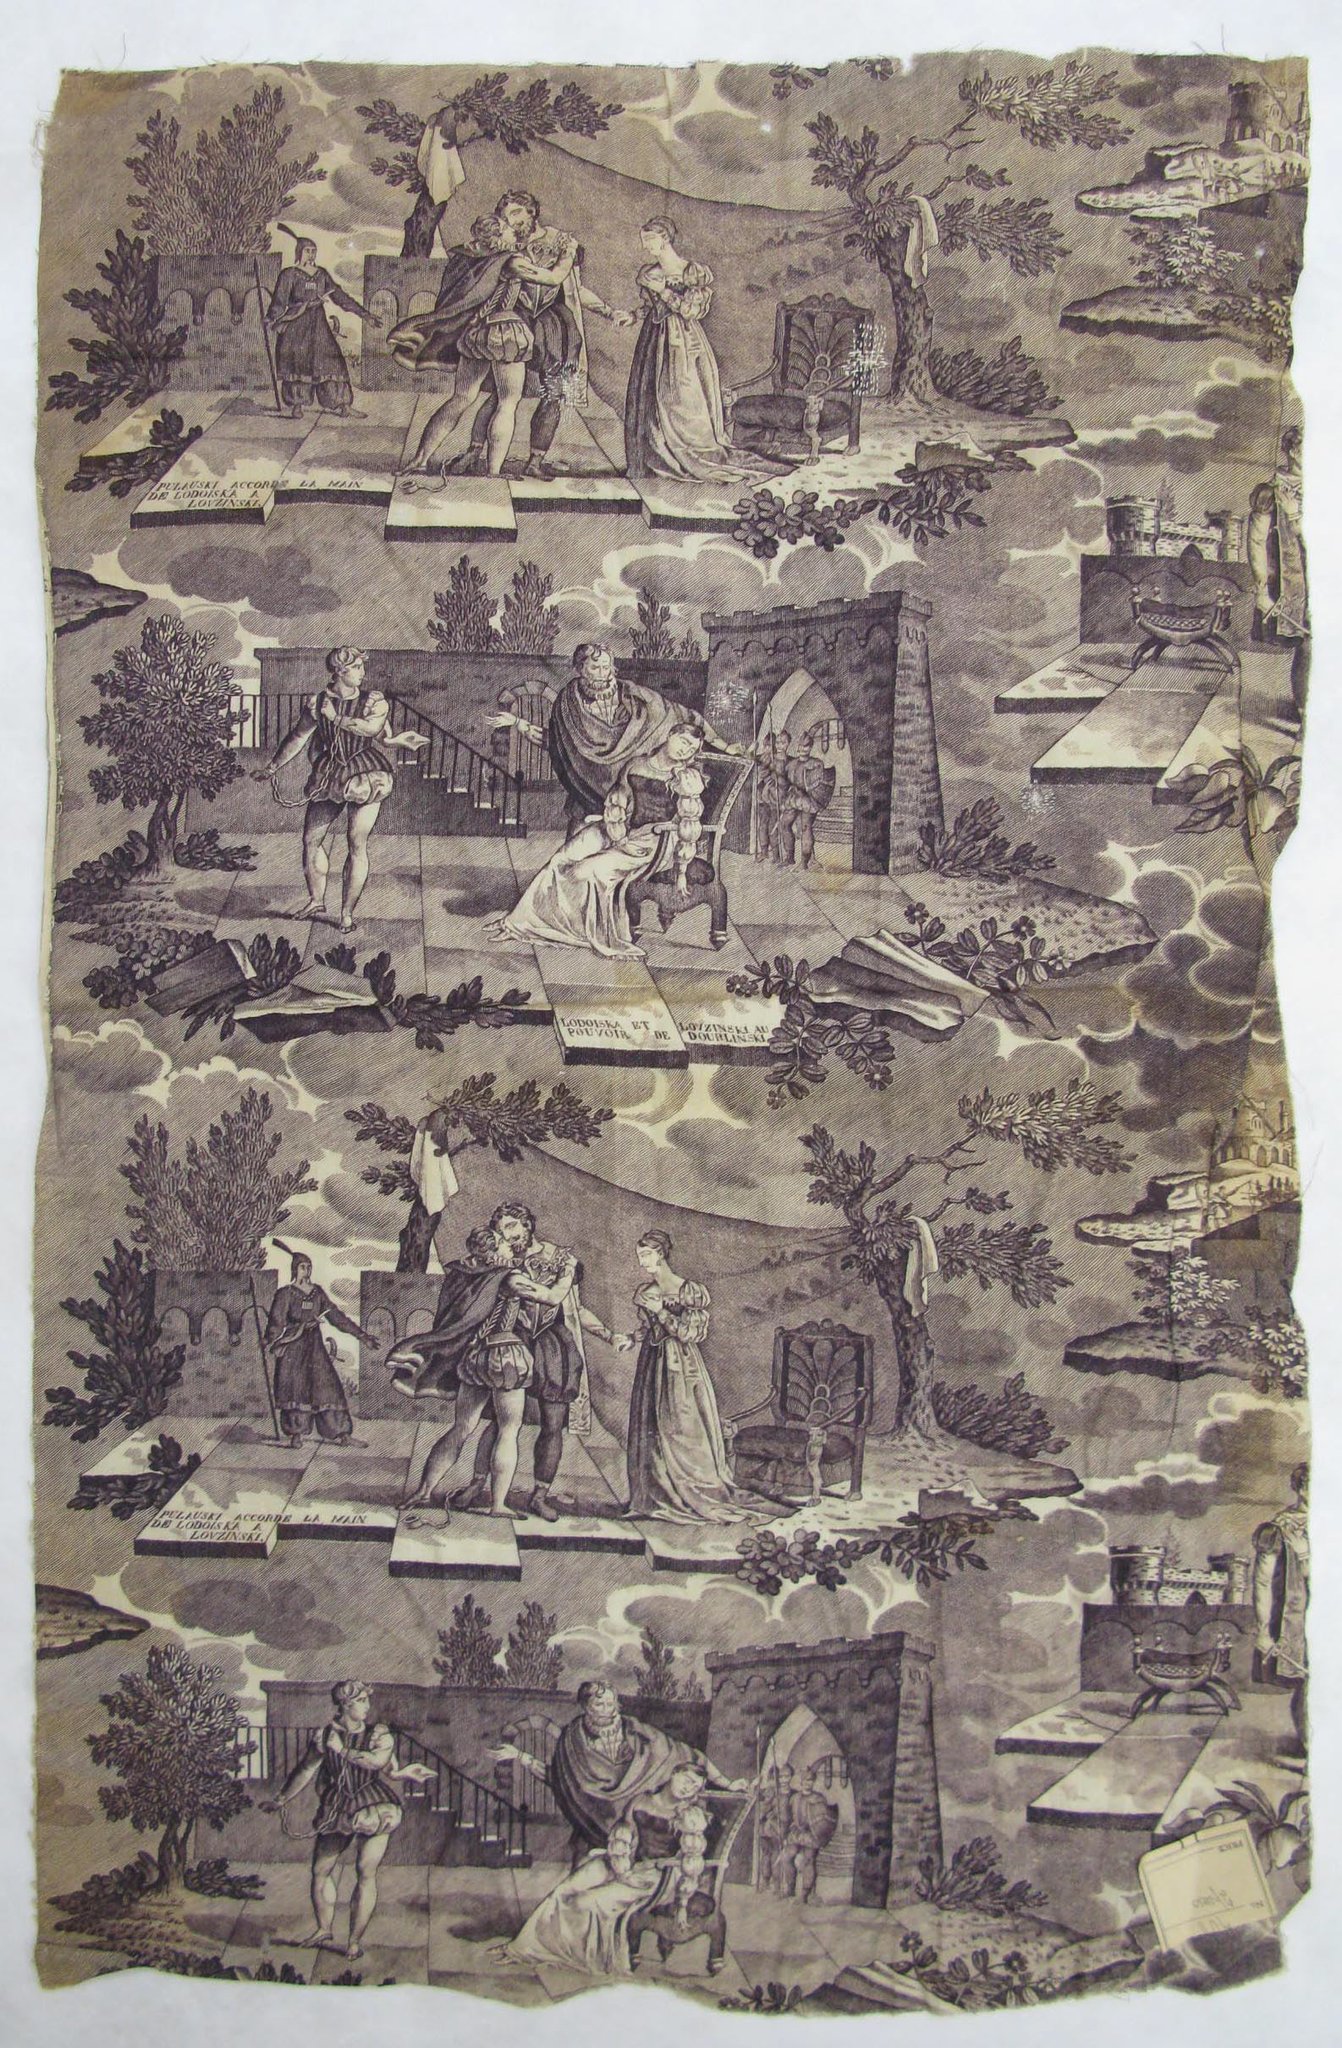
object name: length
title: Scenes from "The Life and Adventures of Chevalier de Faublas" by Jean-Baptiste Louvet de Couvray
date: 1820-1829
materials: cotton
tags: men,women